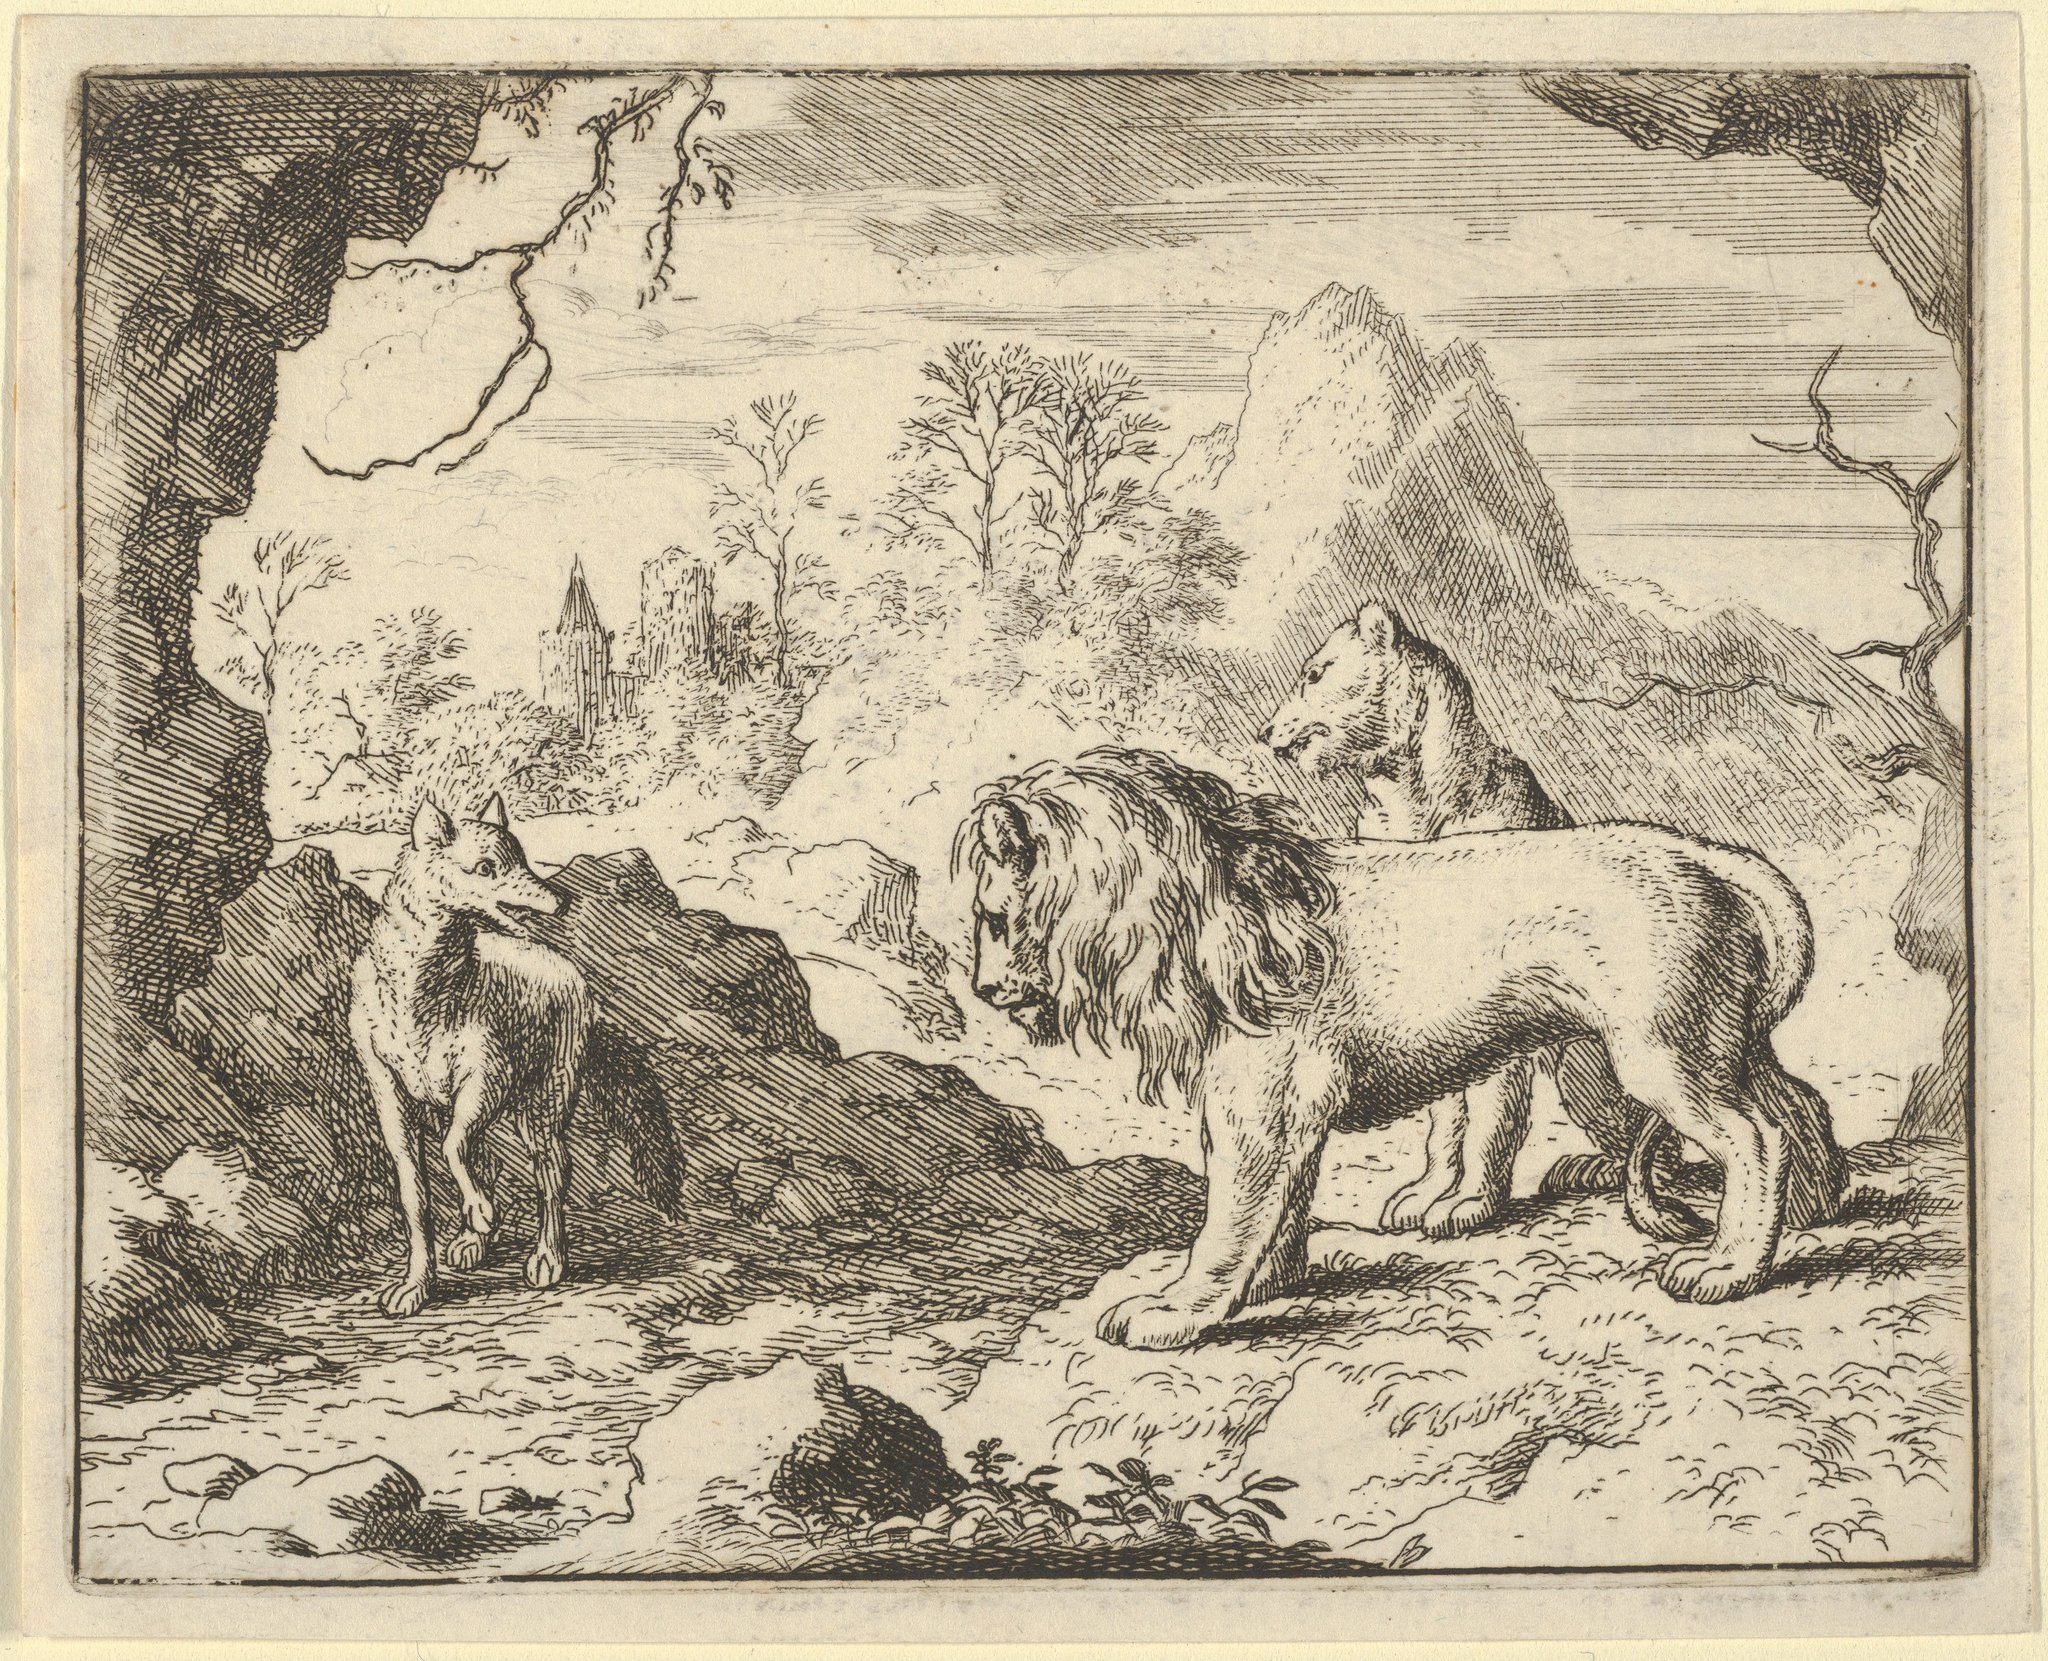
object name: print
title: Renard Convinces the Lion and Lioness of Finding a Treasure His Father Stole from Them from Hendrick van Alcmar's Renard The Fox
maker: allart van everdingen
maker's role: artist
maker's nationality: dutch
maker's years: 1621-1675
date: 1650-1675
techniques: engraving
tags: foxes,lions